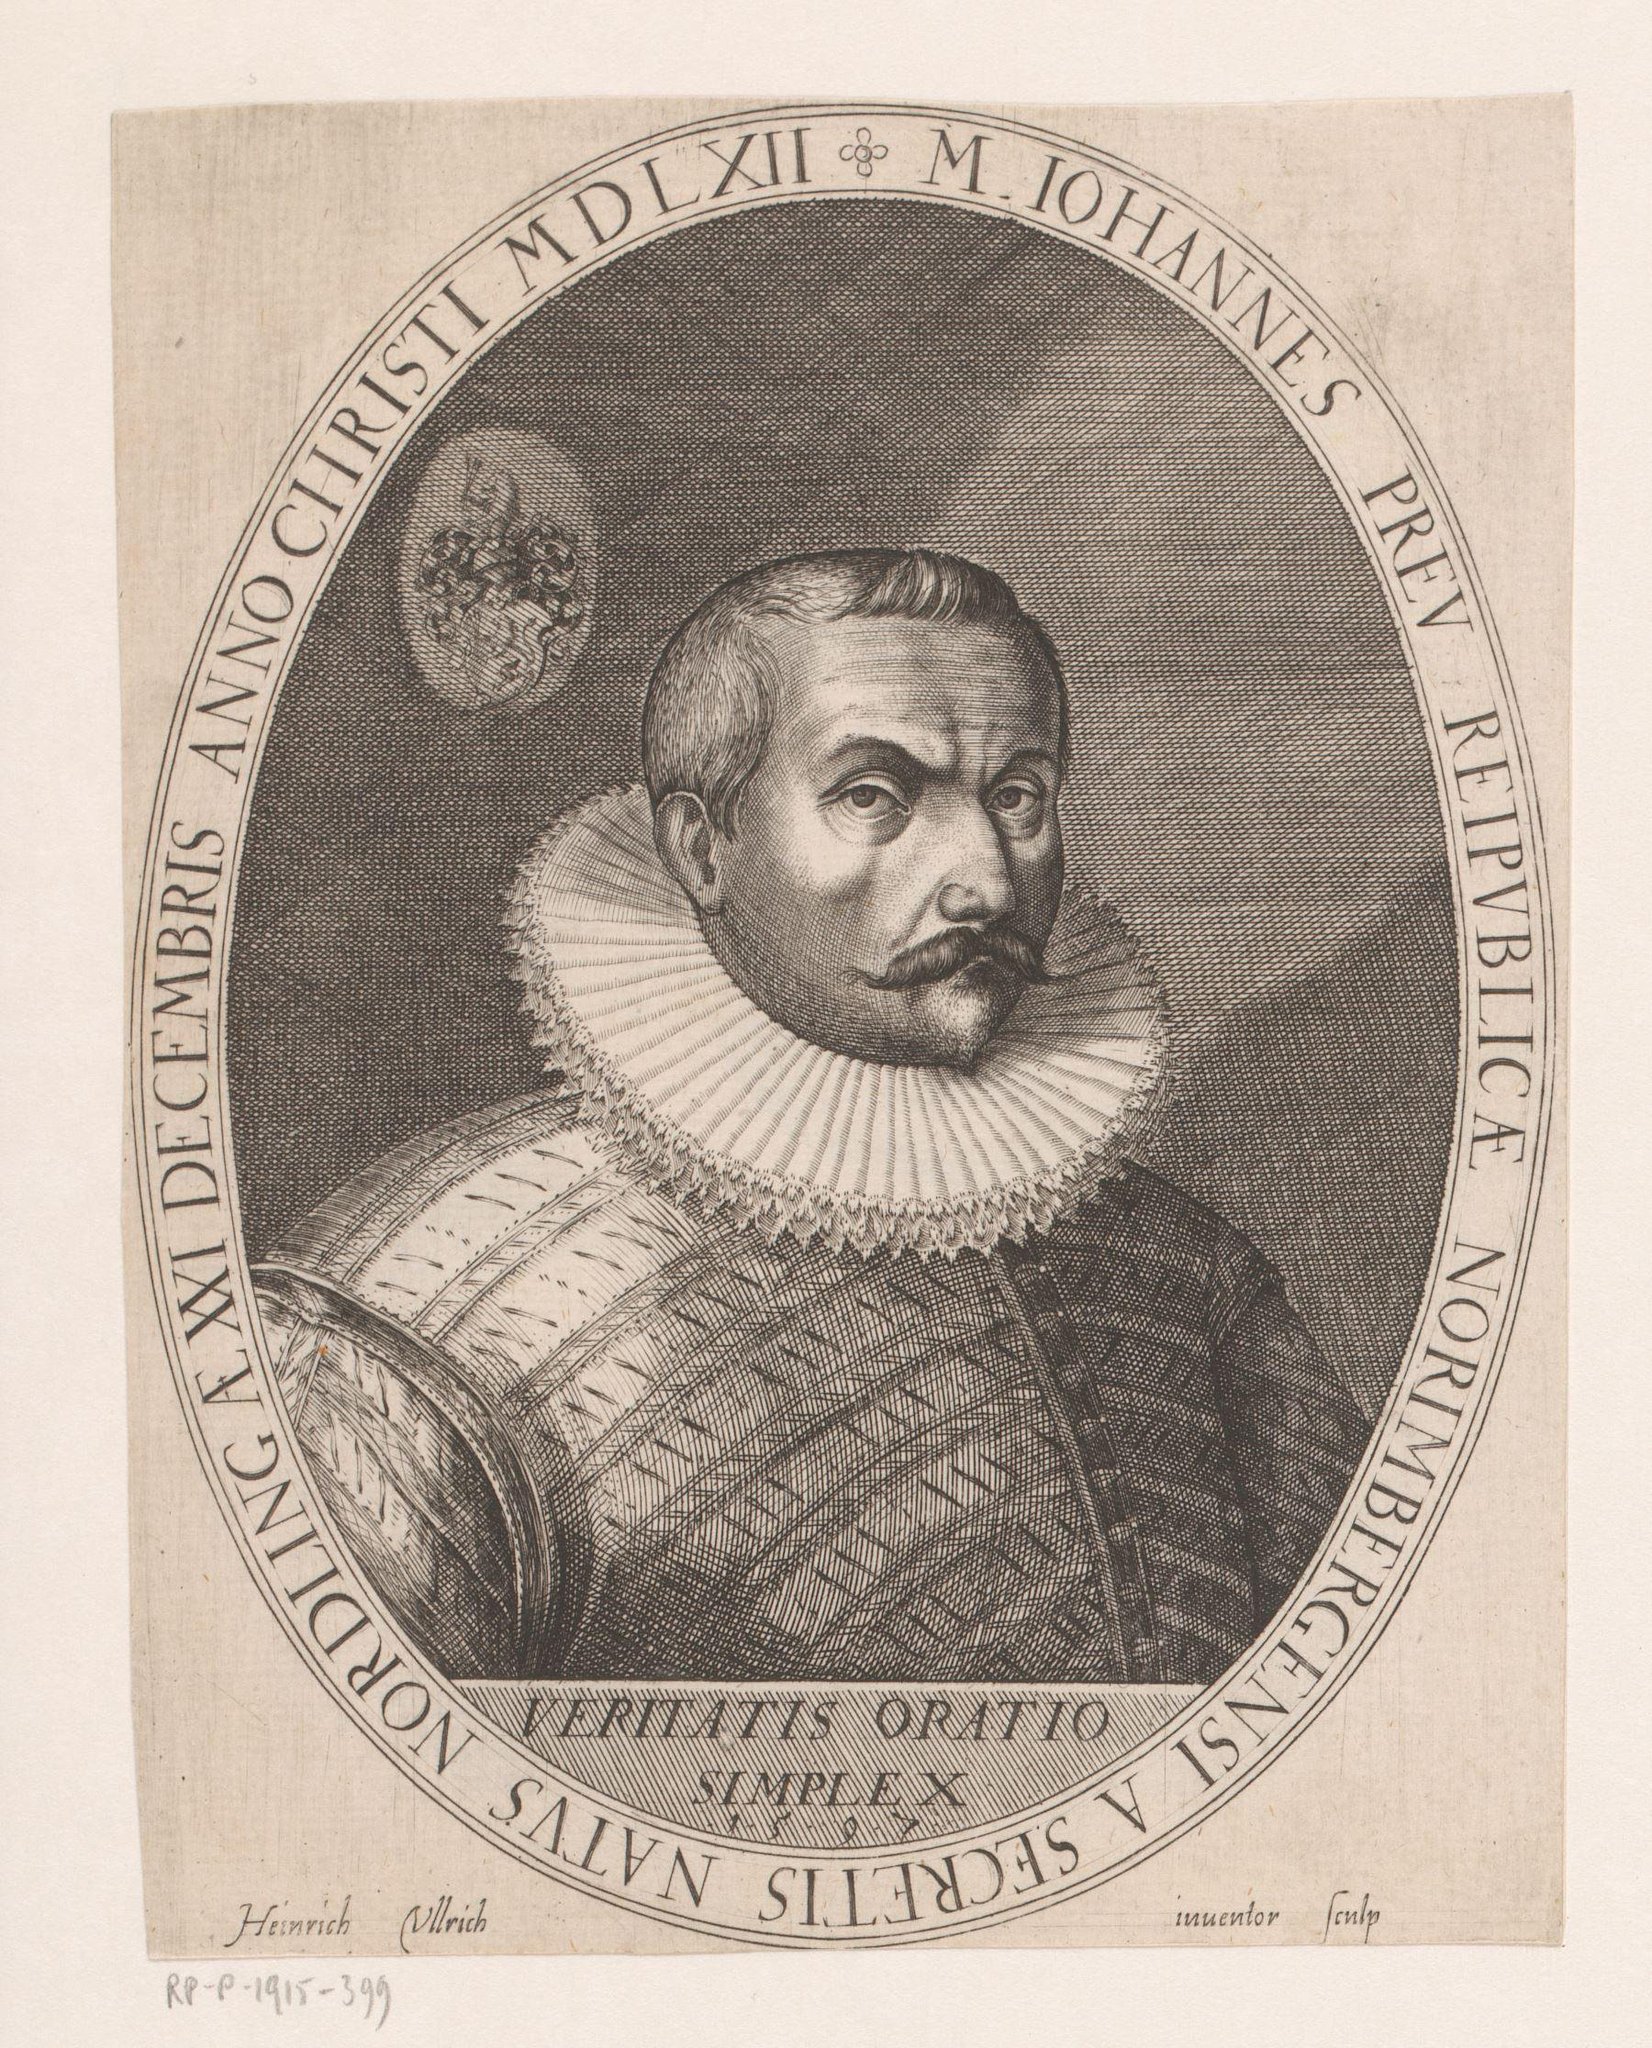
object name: print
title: Portret van Johann Preu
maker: heinrich ulrich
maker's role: draughtsman, painter, print maker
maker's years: 1572-1671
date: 1597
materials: paper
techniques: engraving, intaglio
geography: nuremberg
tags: historical persons, armorial bearing, heraldry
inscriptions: collector's mark: Lugt 2228